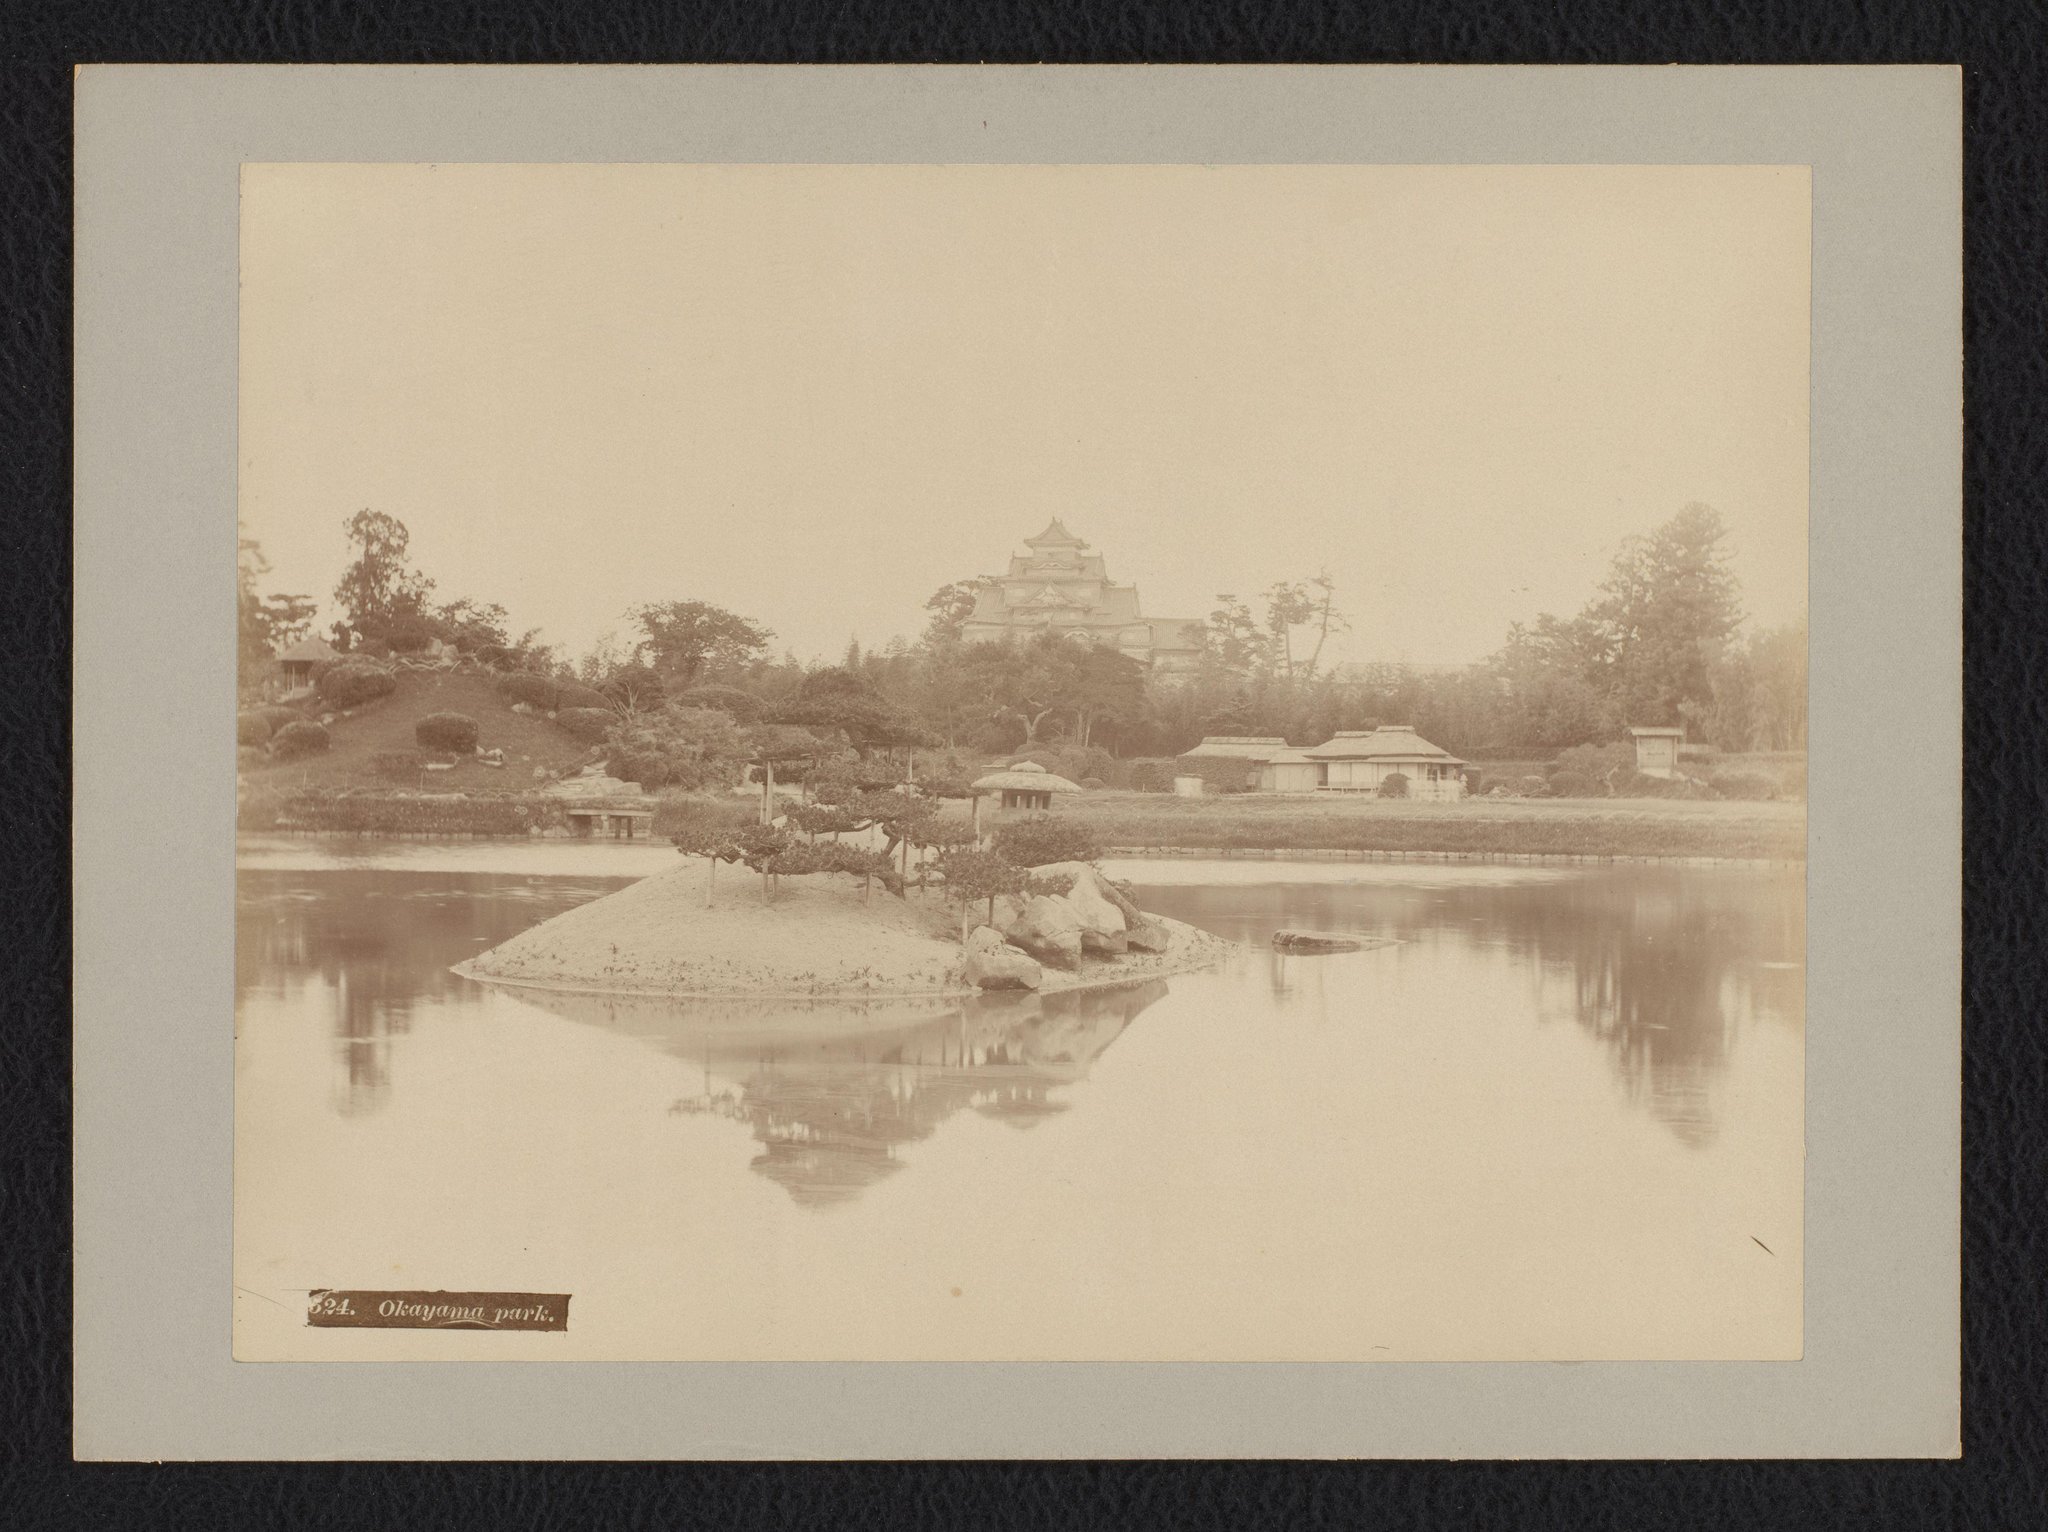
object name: photograph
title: 524. Okayama park.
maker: Anonymous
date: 1895-1915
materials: cardboard, photographic support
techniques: albumen print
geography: okayama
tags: okayama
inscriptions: number: ‘2.’